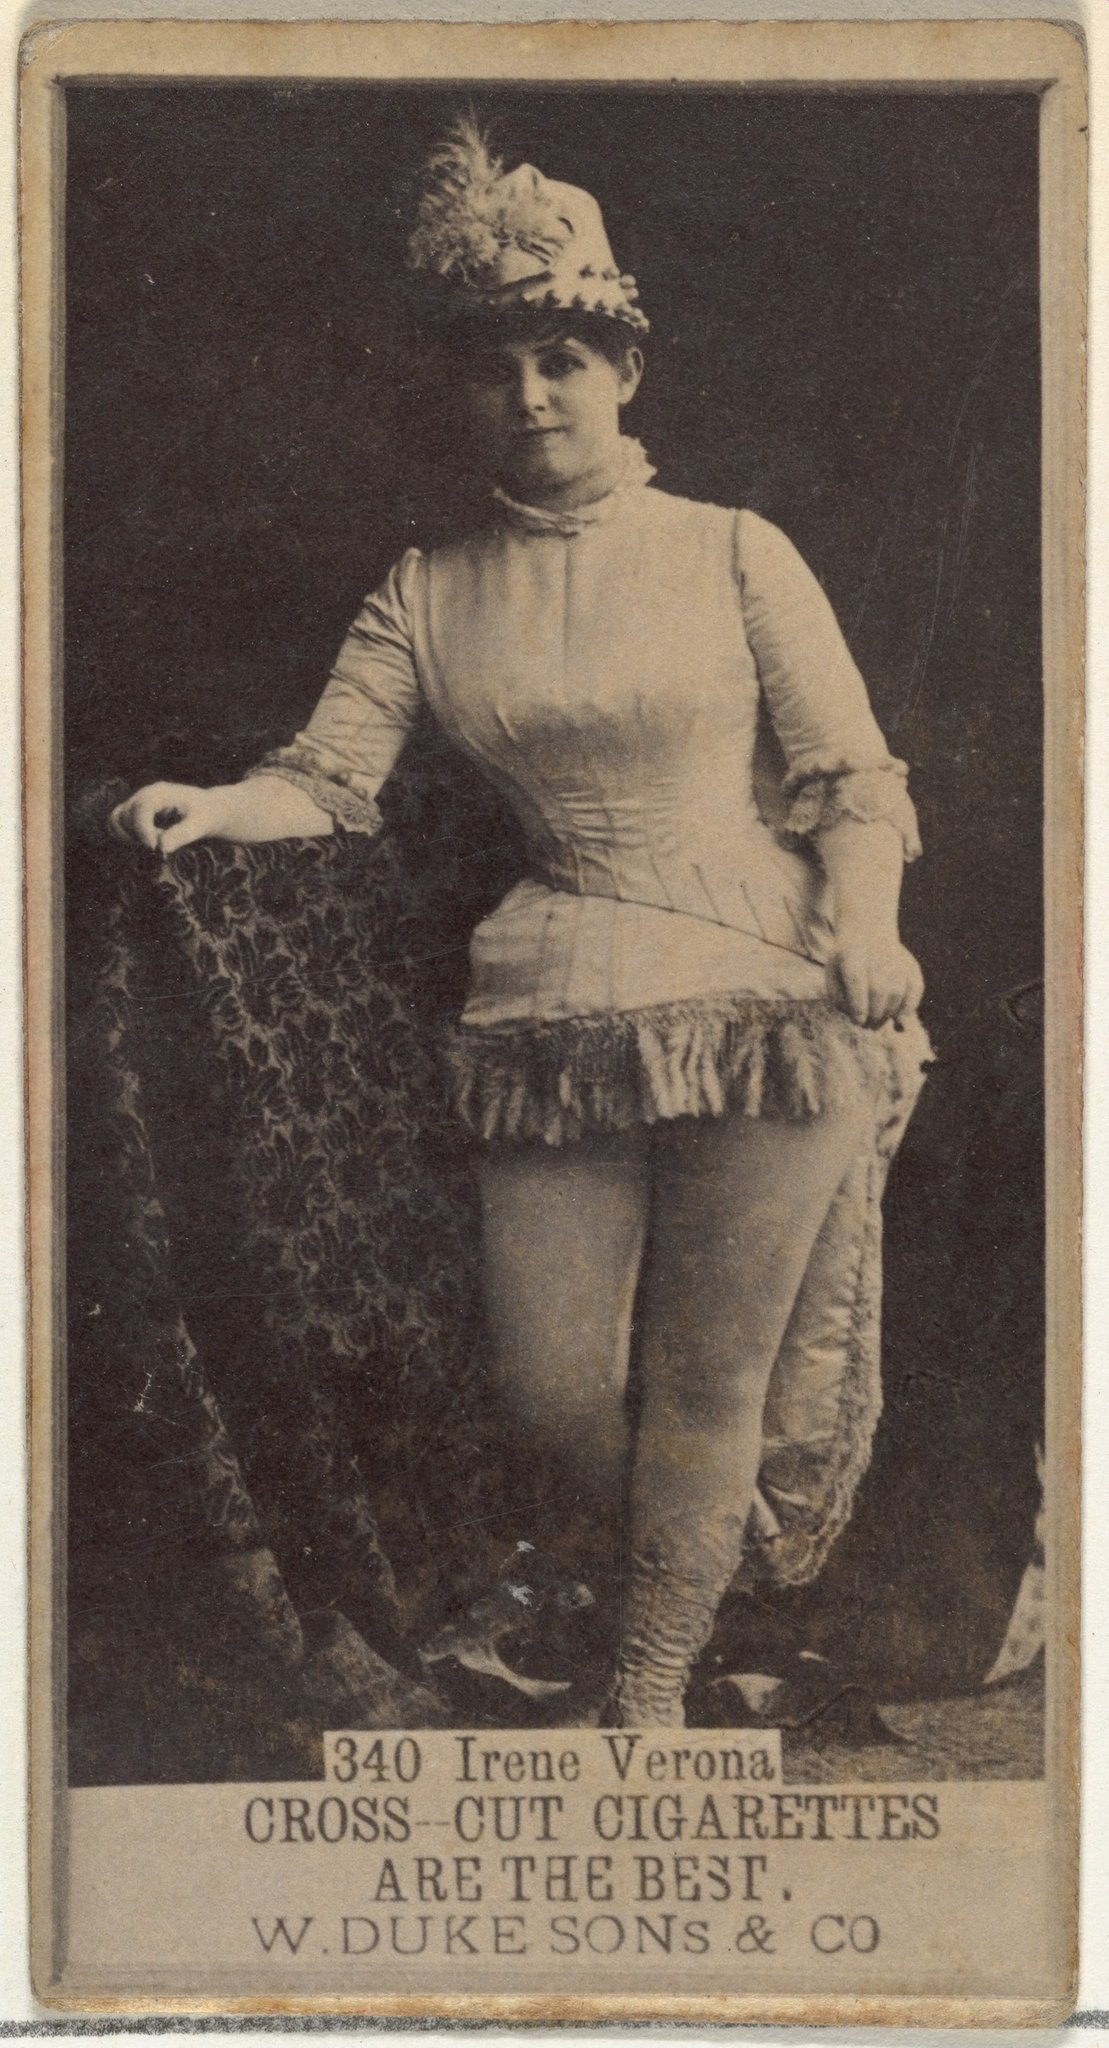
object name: photograph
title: Card Number 340, Irene Verona, from the Actors and Actresses series (N145-3) issued by Duke Sons & Co. to promote Cross Cut Cigarettes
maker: w. duke, sons & co.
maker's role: publisher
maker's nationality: american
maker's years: 1870-1920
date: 1880-1889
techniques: albumen silver print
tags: portraits,women,actresses